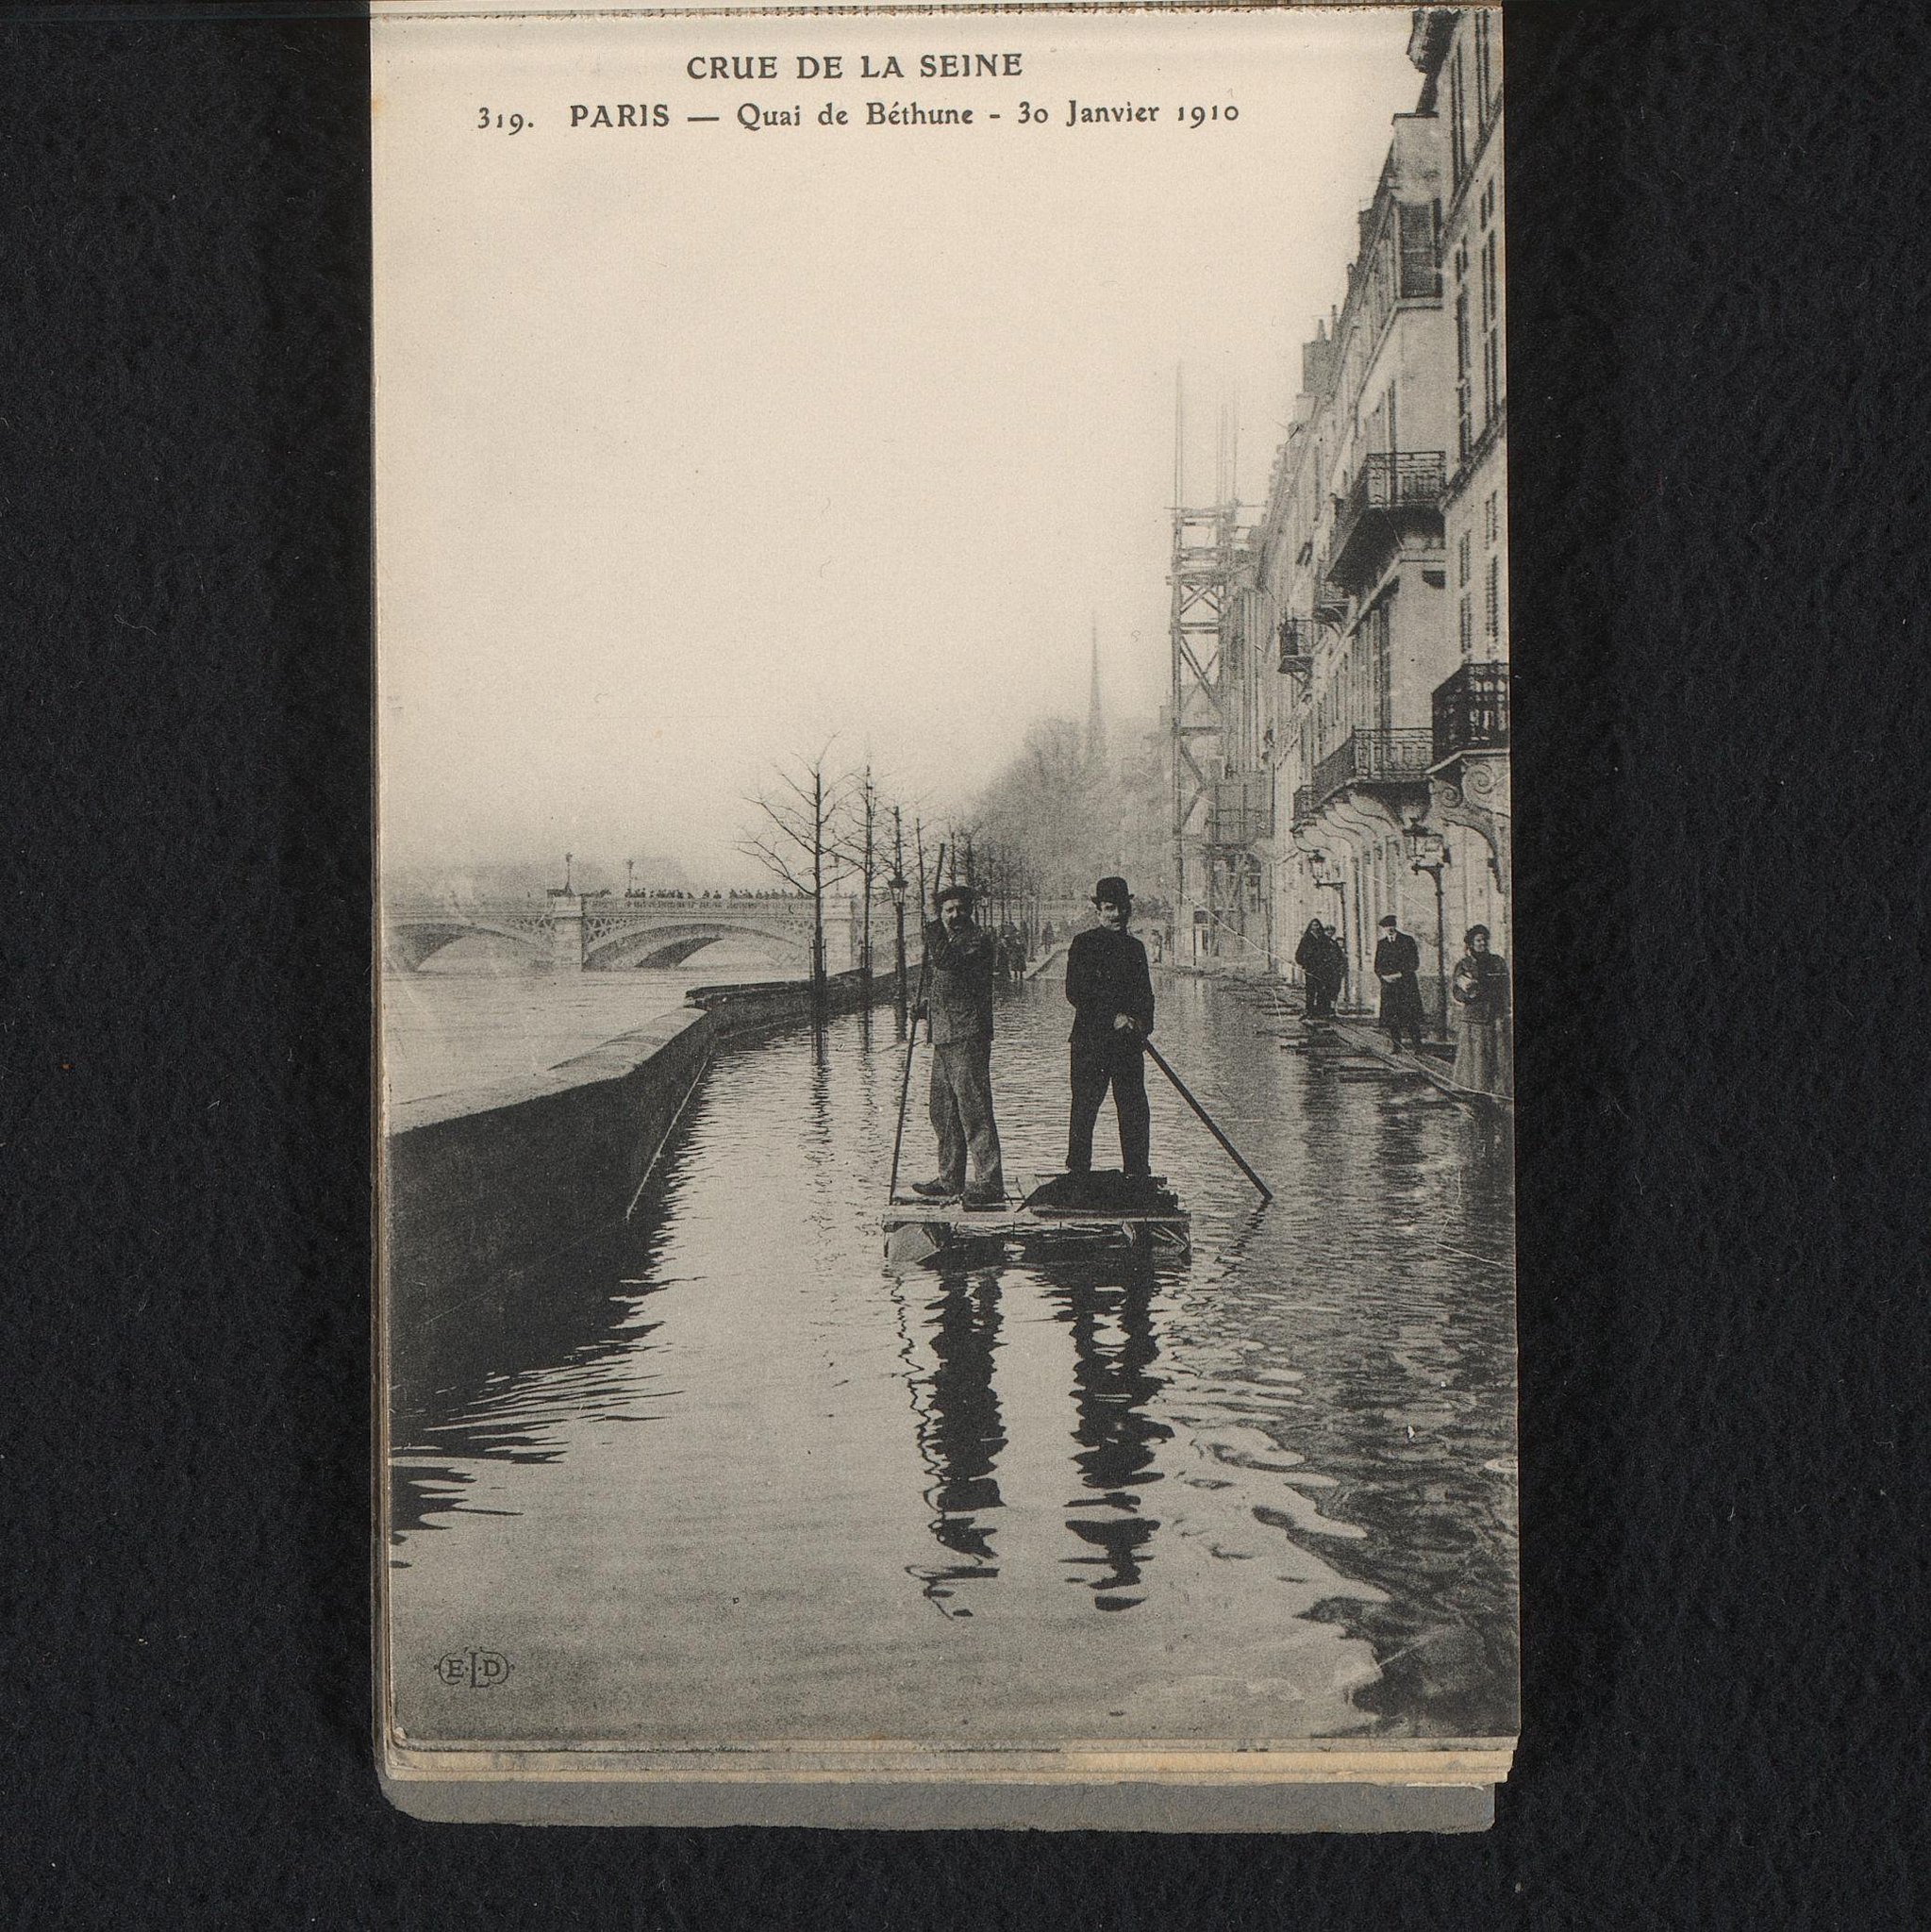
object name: photomechanical print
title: Crue de la Seine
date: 1910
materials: cardboard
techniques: photograph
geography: paris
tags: flood, raft, city-view, and landscape with man-made constructions (+ city(-scape) with figures, staffage), paris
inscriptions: date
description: Prentbriefkaart maakt deel uit van een album.